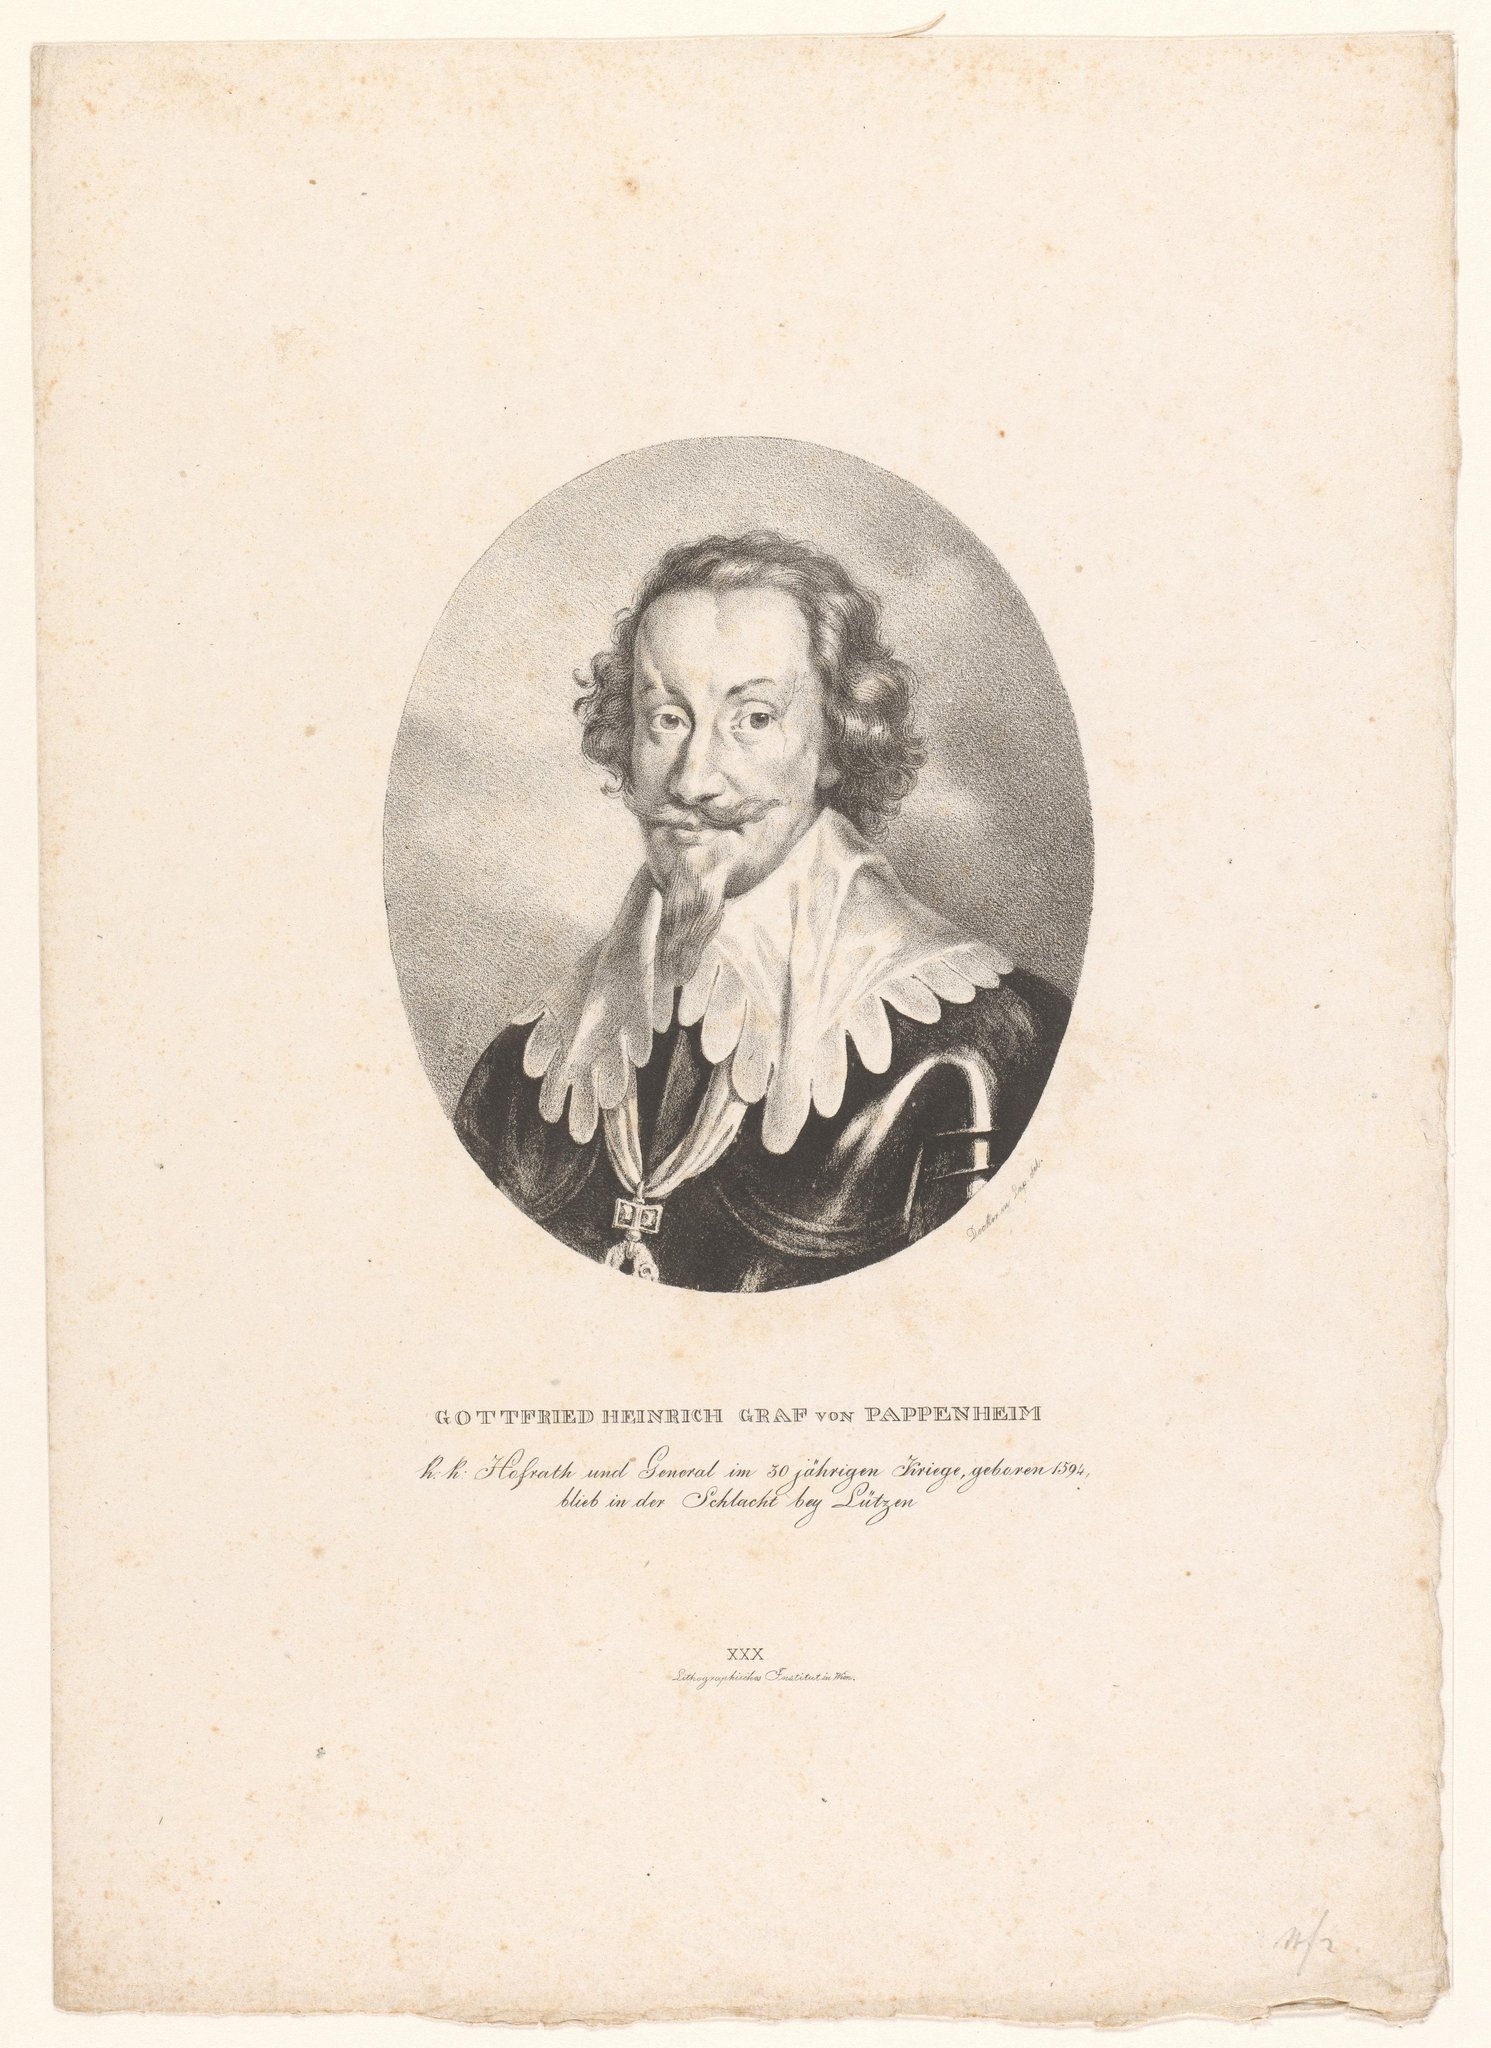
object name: print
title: Portret van Gottfried Heinrich graaf zu Pappenheim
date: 1831-1855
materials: paper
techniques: lithograph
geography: vienna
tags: adult man, historical persons, beard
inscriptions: collector's mark: Lugt 2228